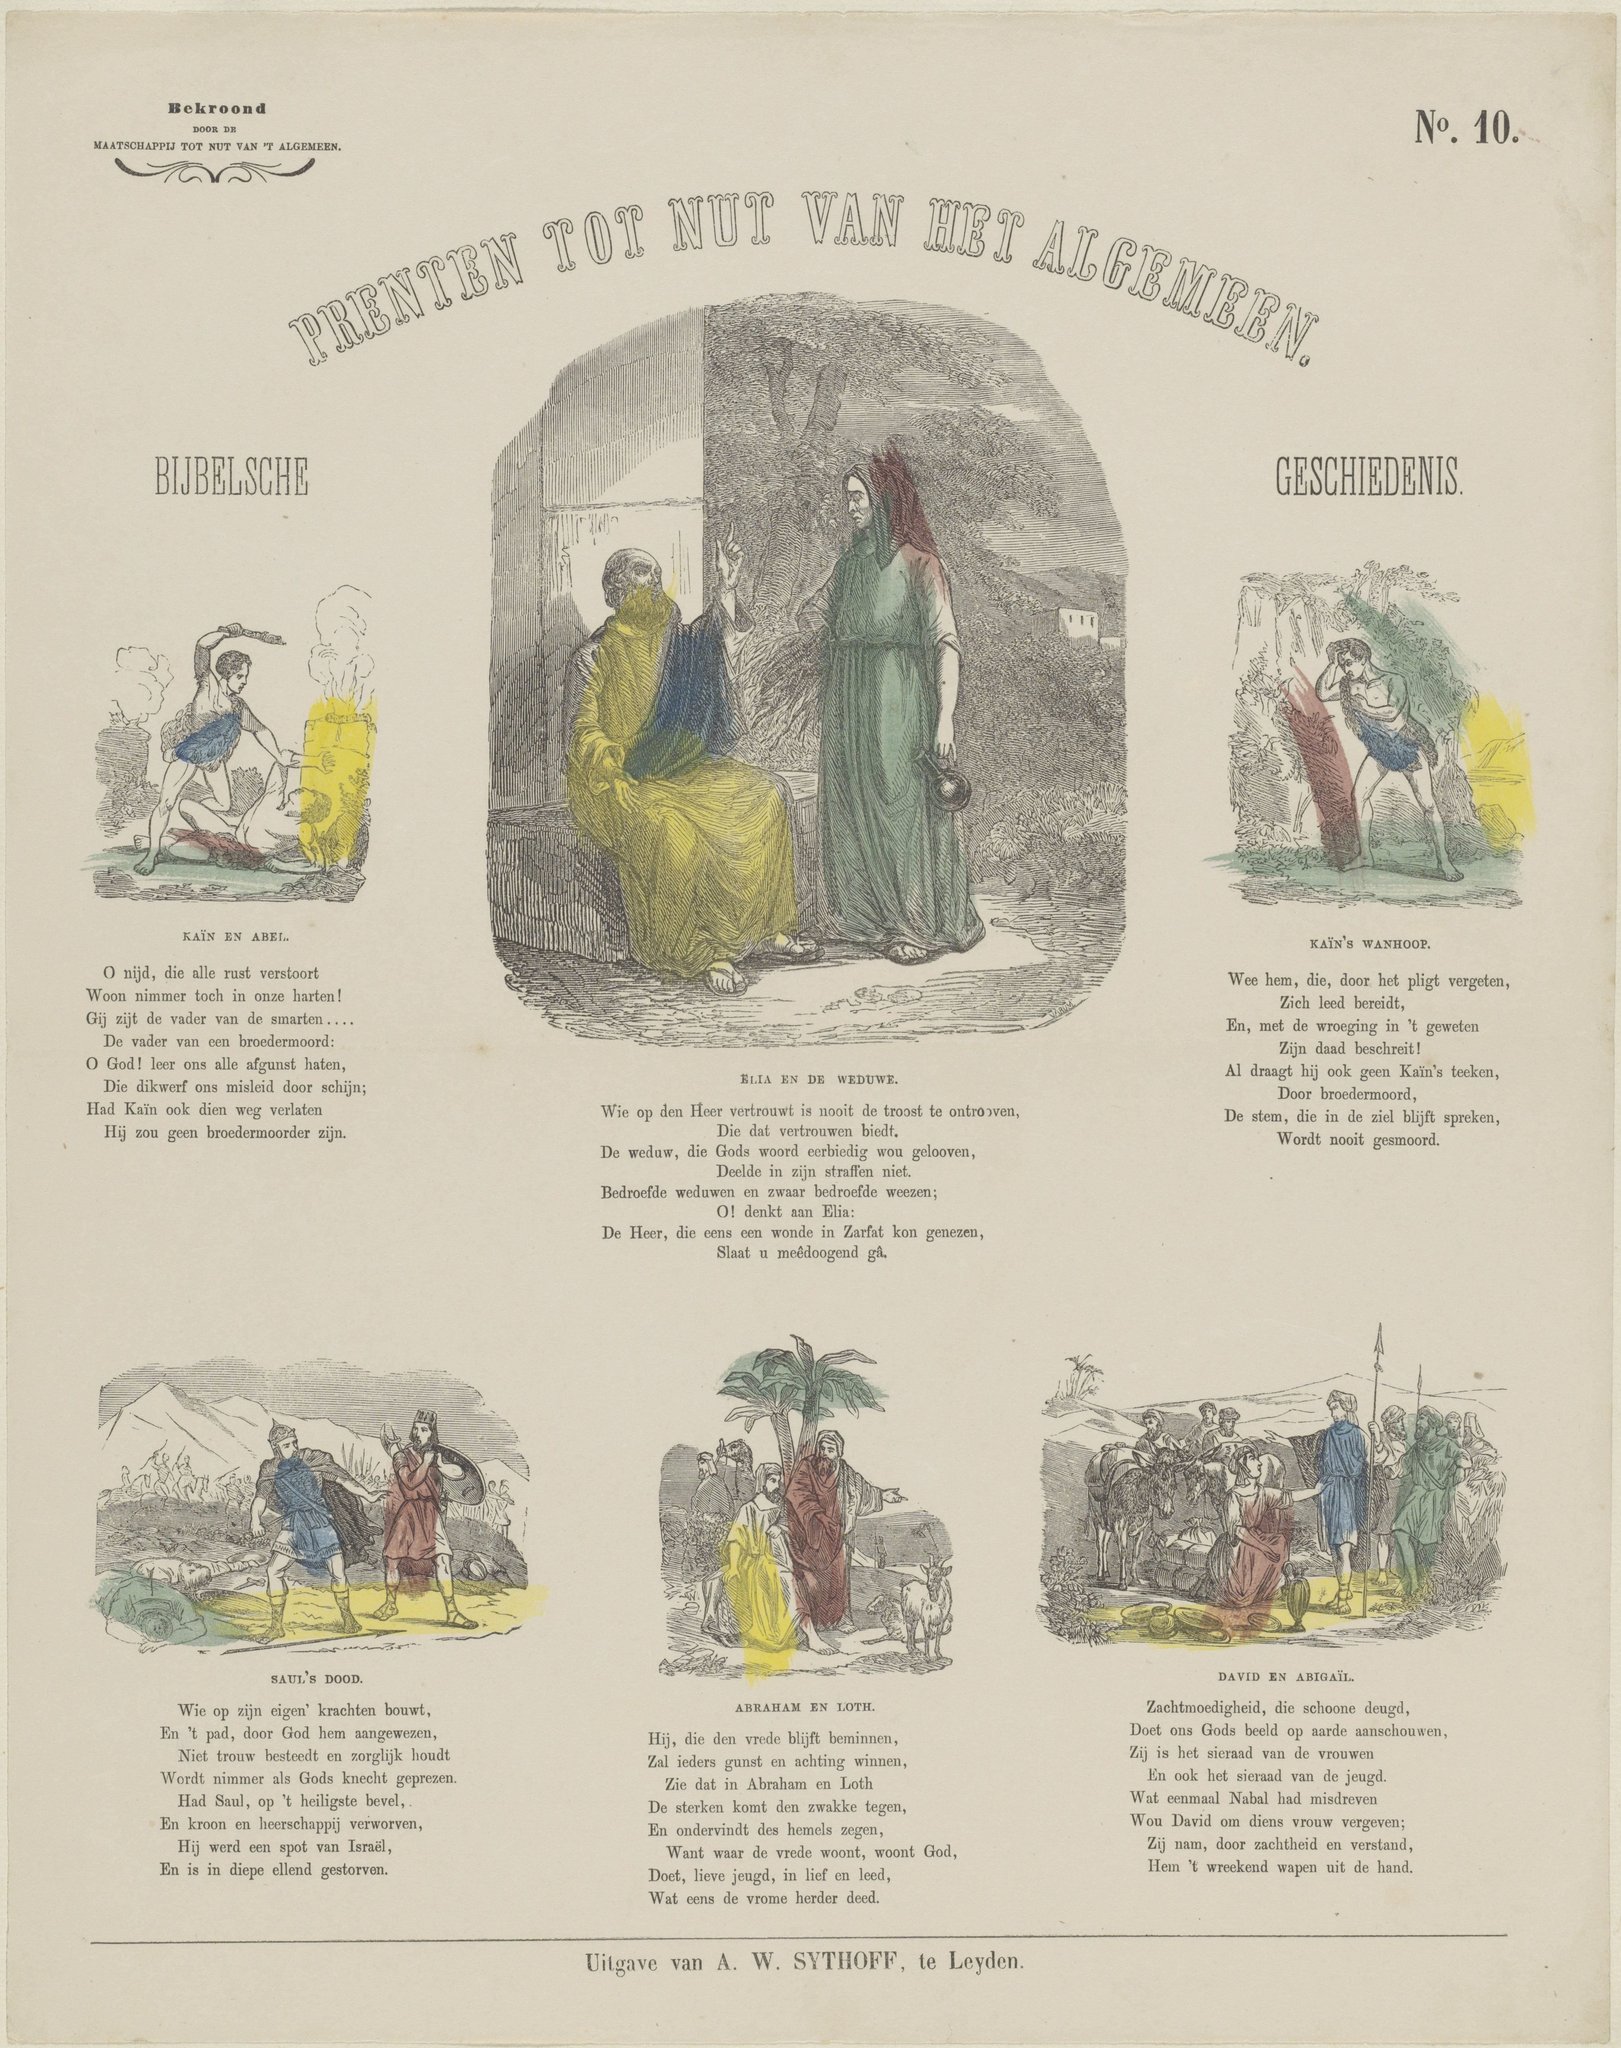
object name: popular print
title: Prenten tot nut van het algemeen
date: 1861-1929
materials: paper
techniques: colour, letterpress printing, engraving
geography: europe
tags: david and abigail (1 samuel 25), abel's death, story of saul's death, old testament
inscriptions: collector's mark: Lugt 2760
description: Blad met 6 voorstellingen uit het Oude Testament. Onder elke voorstelling een verwijzing naar een bijbeltekst en een vers. Genummerd rechtsboven: No. 10. Linksboven: Bekroond door de Maatschappij tot Nut van 't Algemeen.